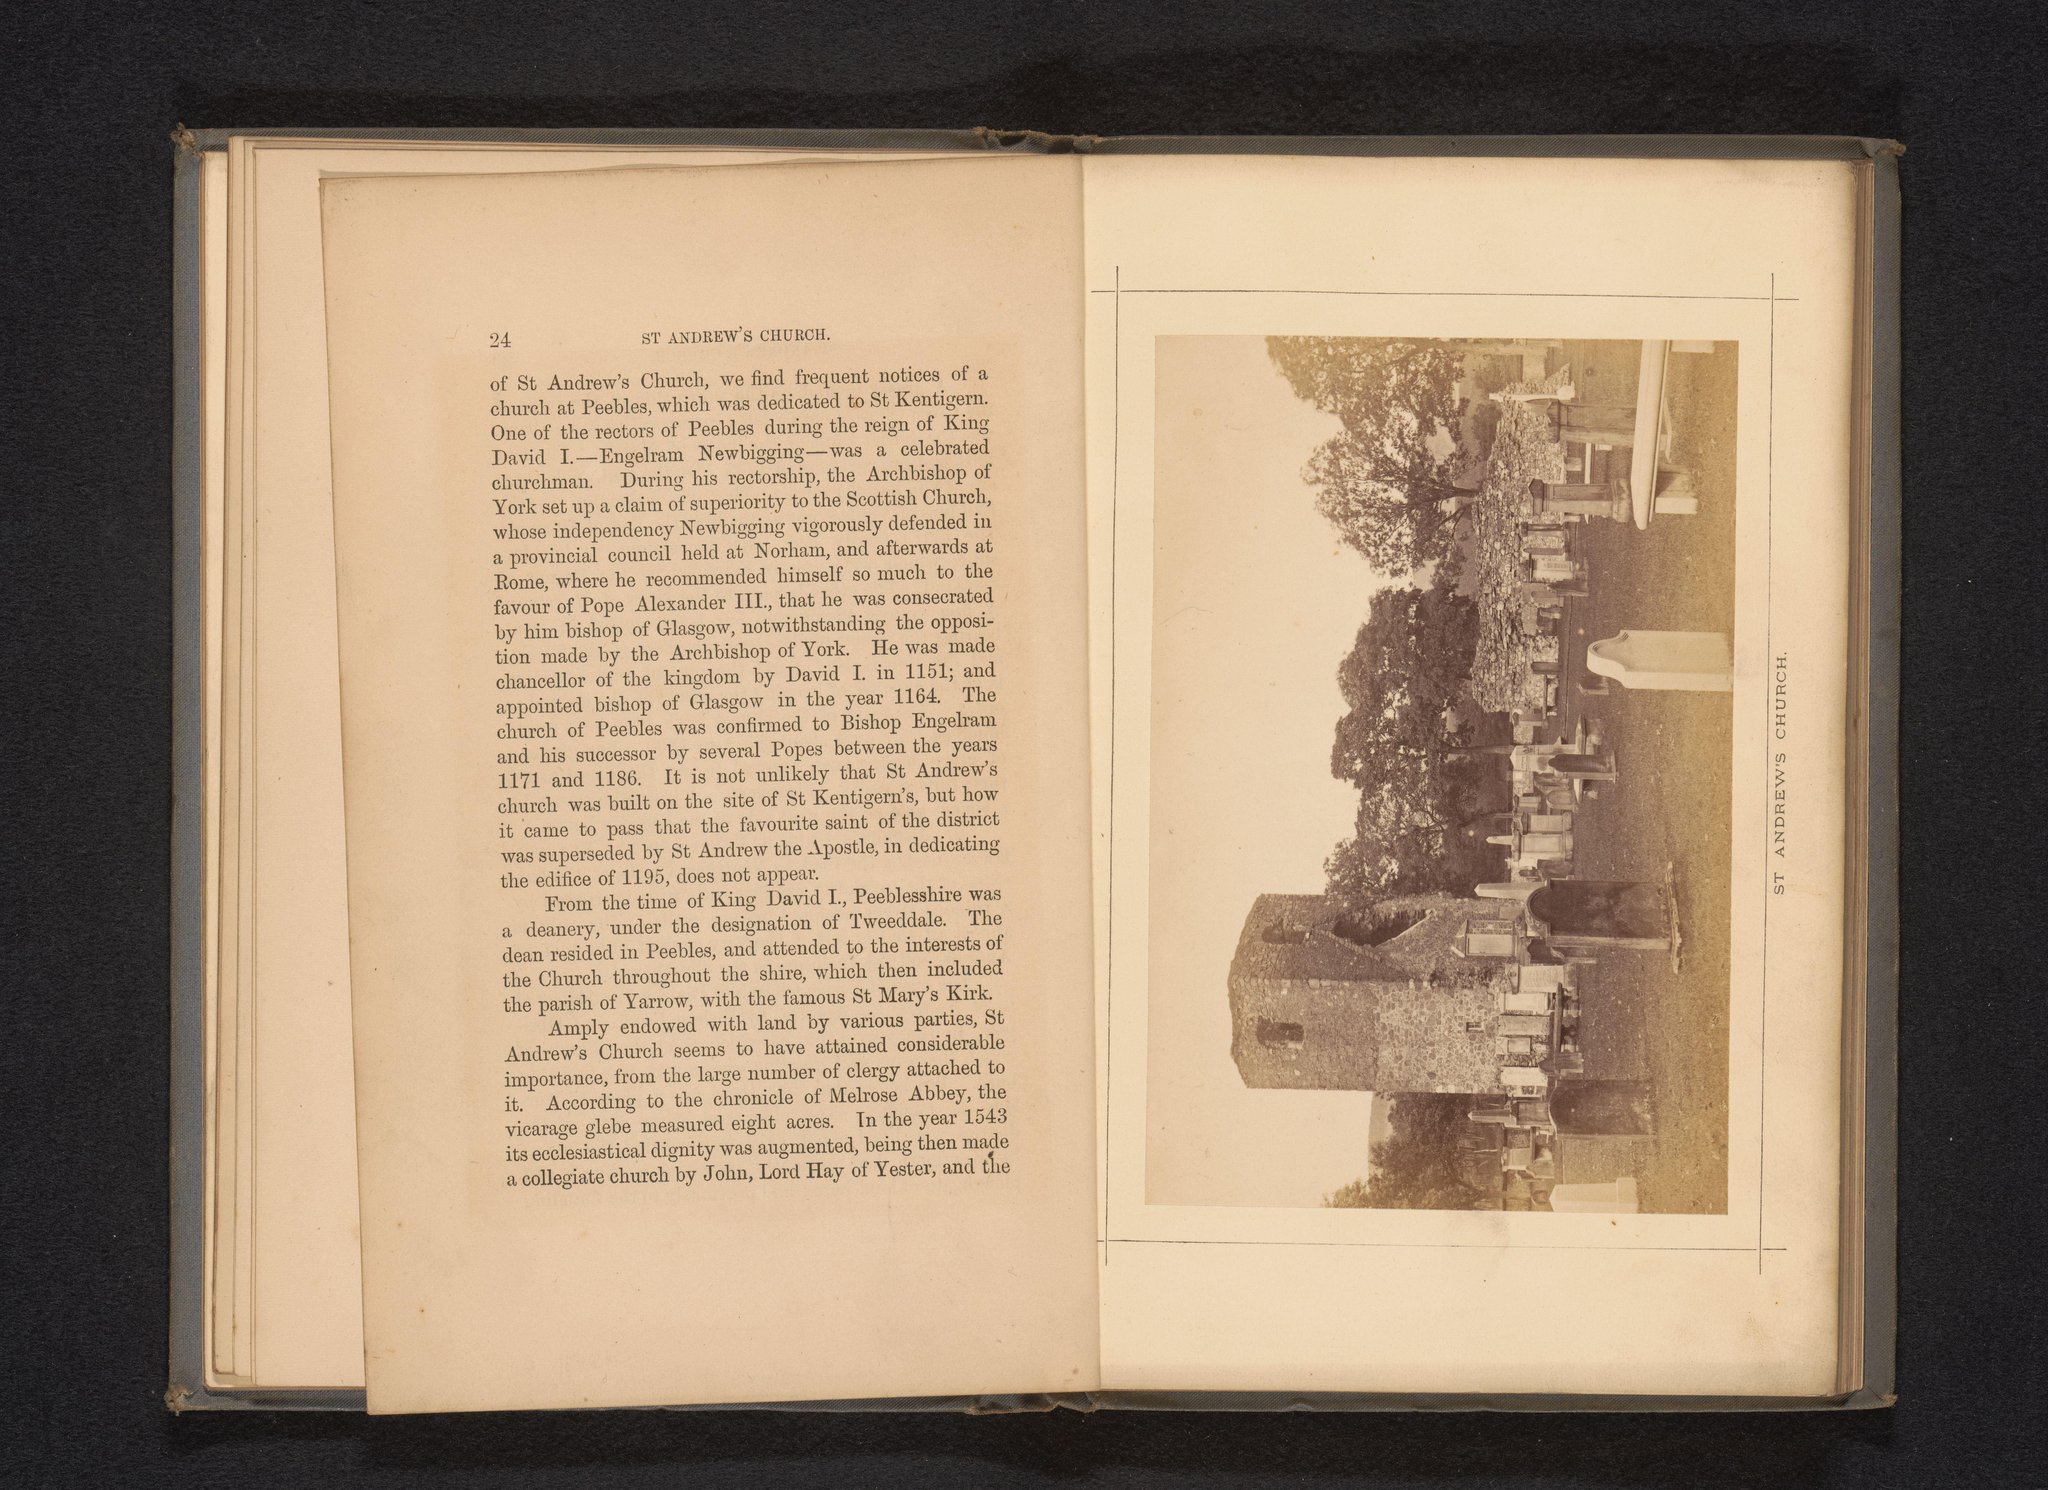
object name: photograph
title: Gezicht op de ruïne van een kerk te Peebles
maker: george washington wilson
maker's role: publisher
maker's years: 1823-1893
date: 1876-1881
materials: photographic support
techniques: albumen print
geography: peebles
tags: ruin of church, monastery, etc., churchyard, cemetery